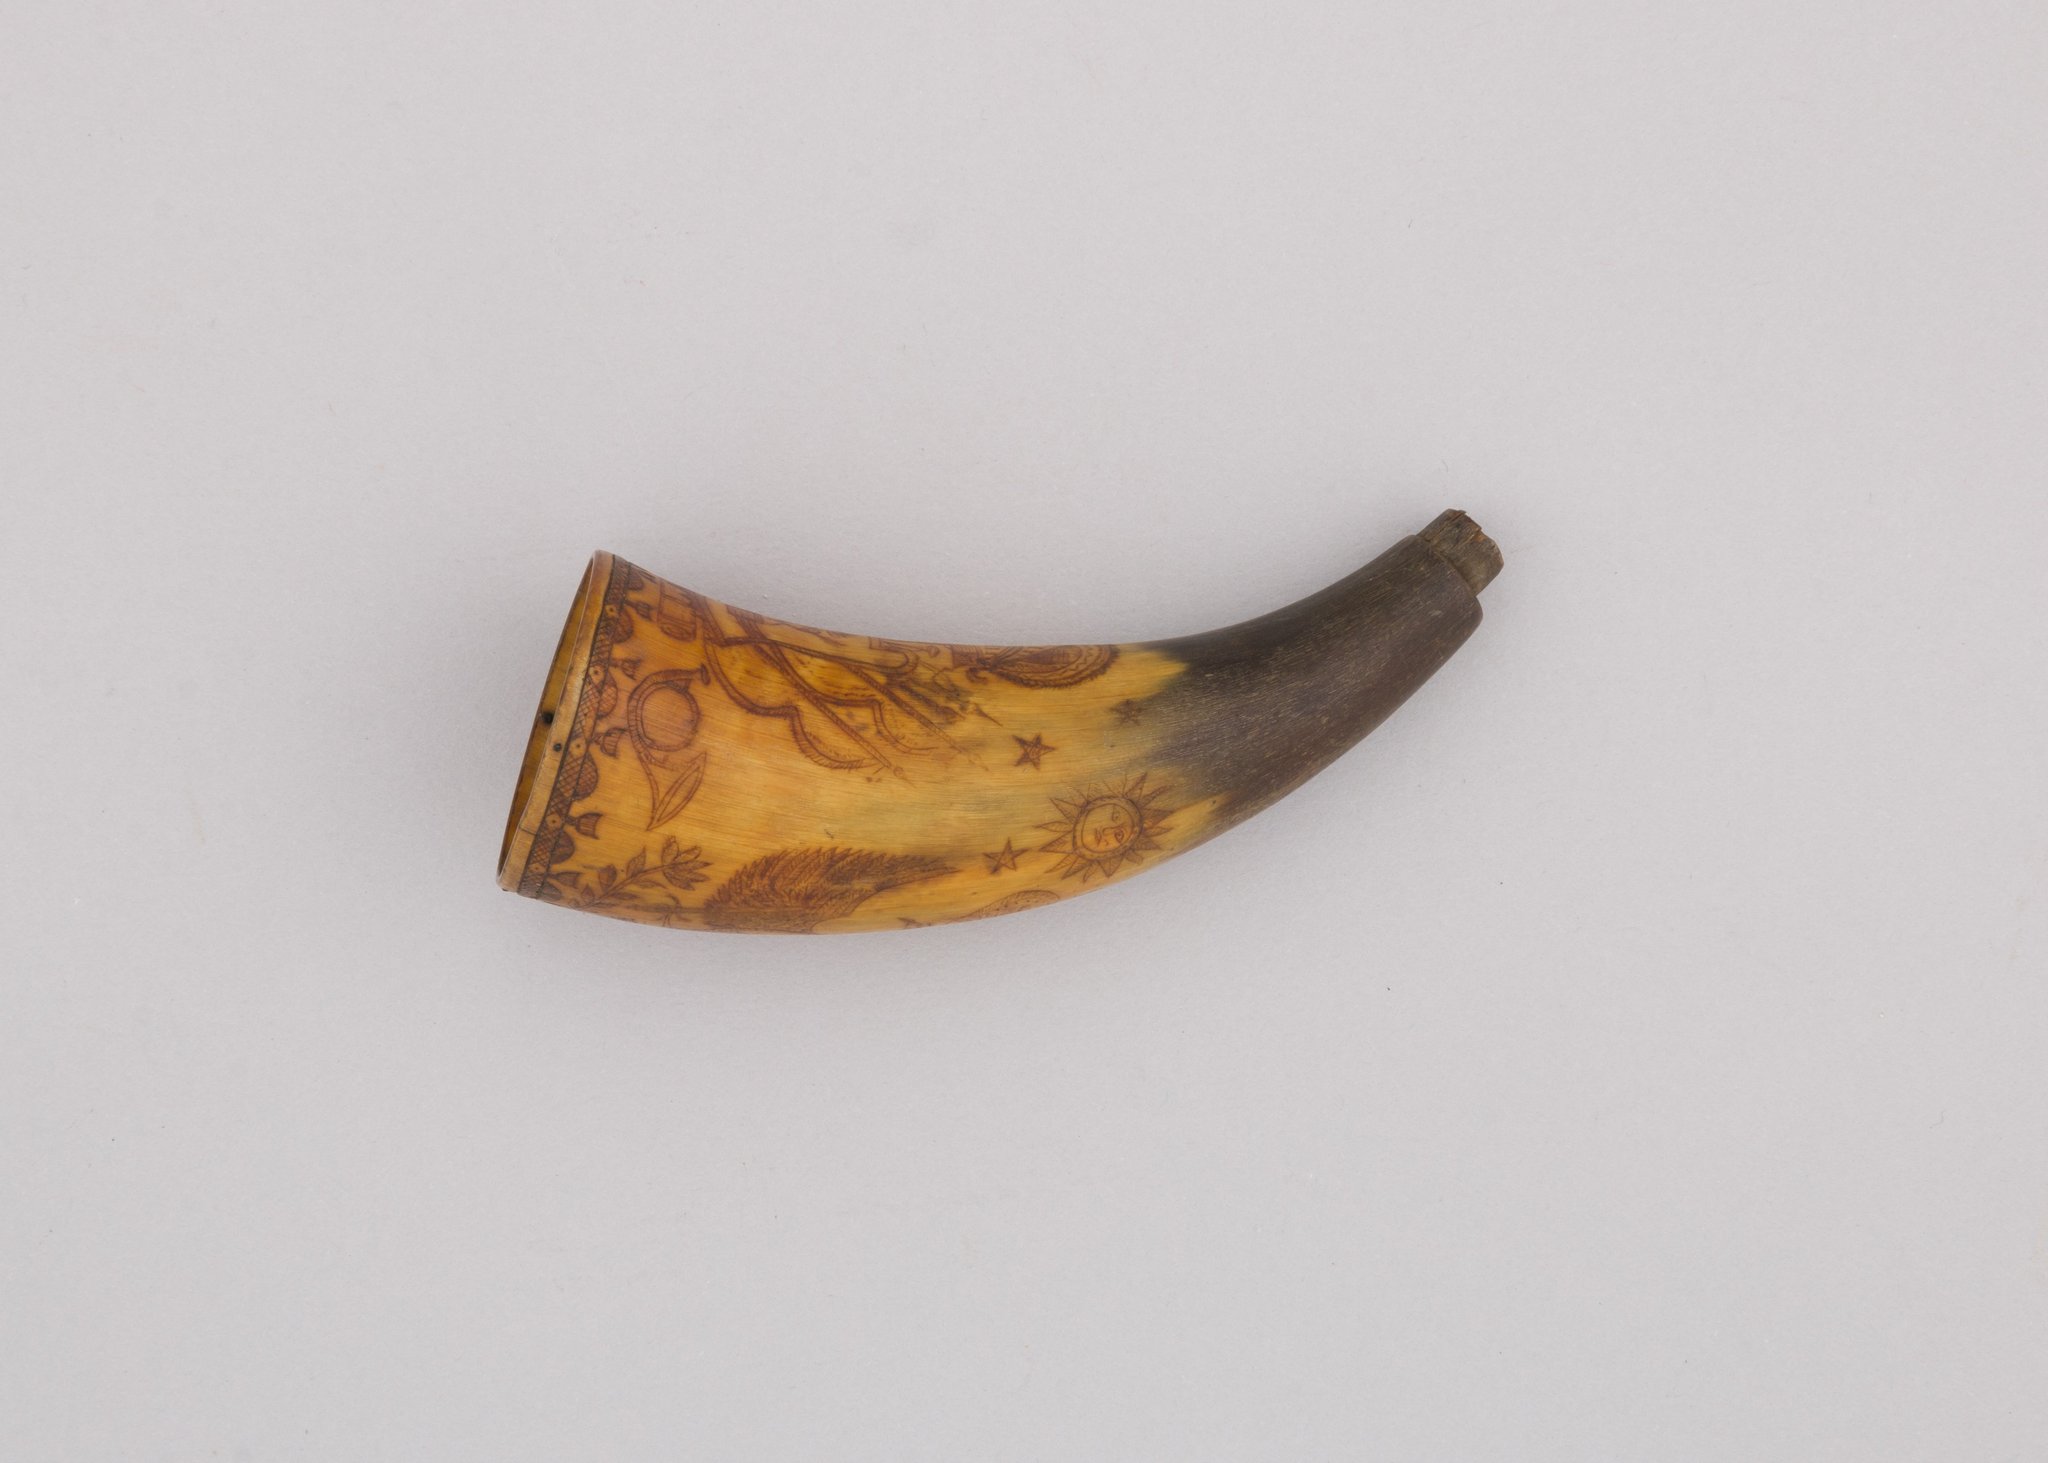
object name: powder horn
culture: american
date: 1767-1800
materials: horn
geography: united states